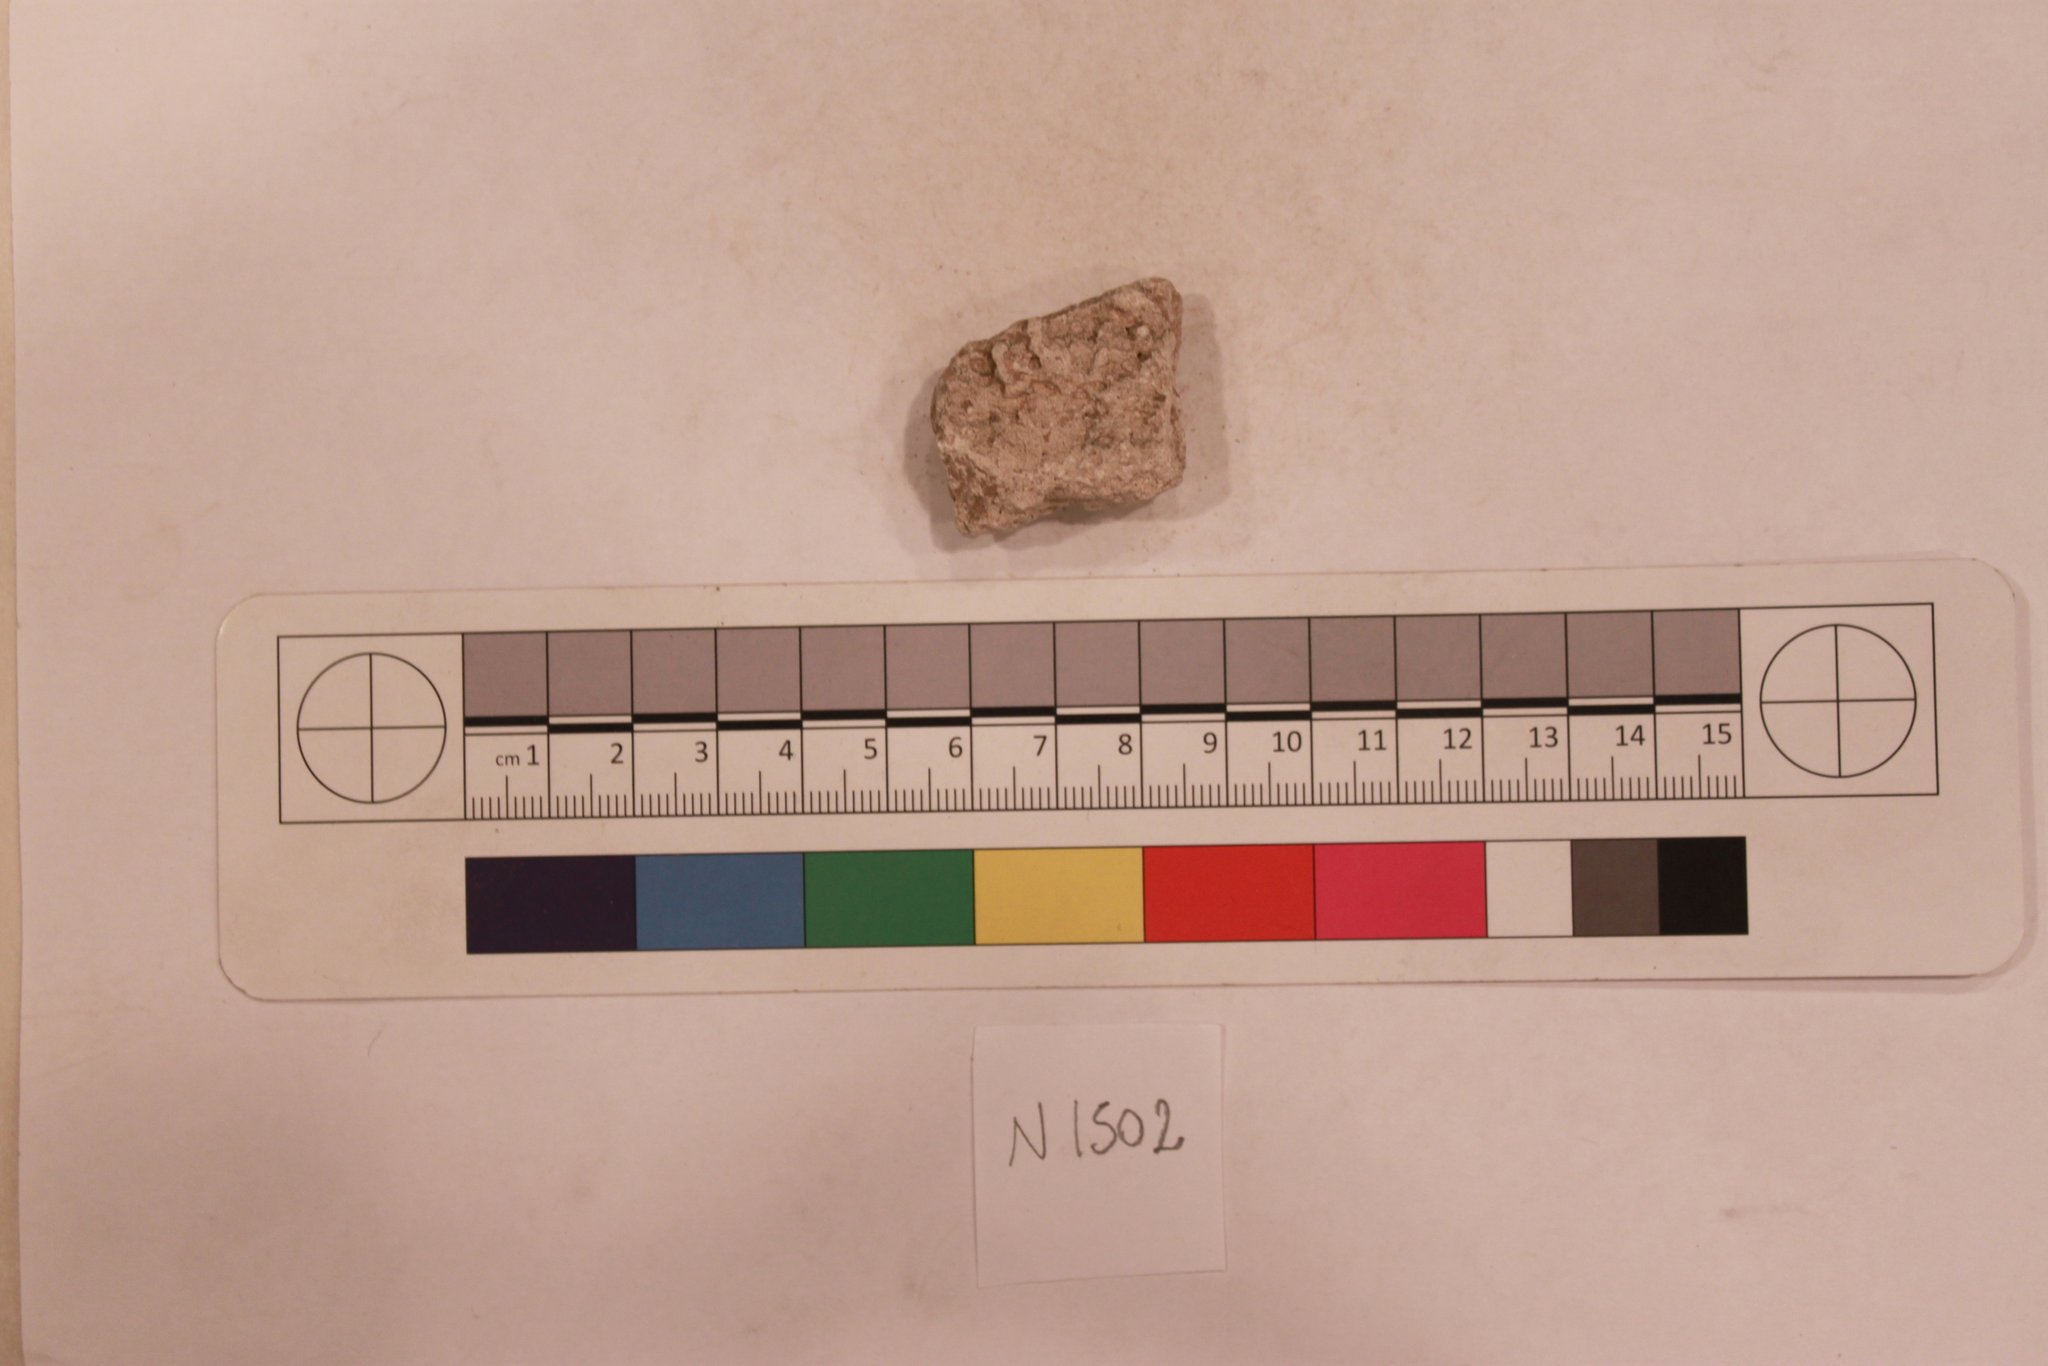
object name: fragment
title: Stucco Fragment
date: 701-1200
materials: plaster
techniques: carving, painting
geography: iran